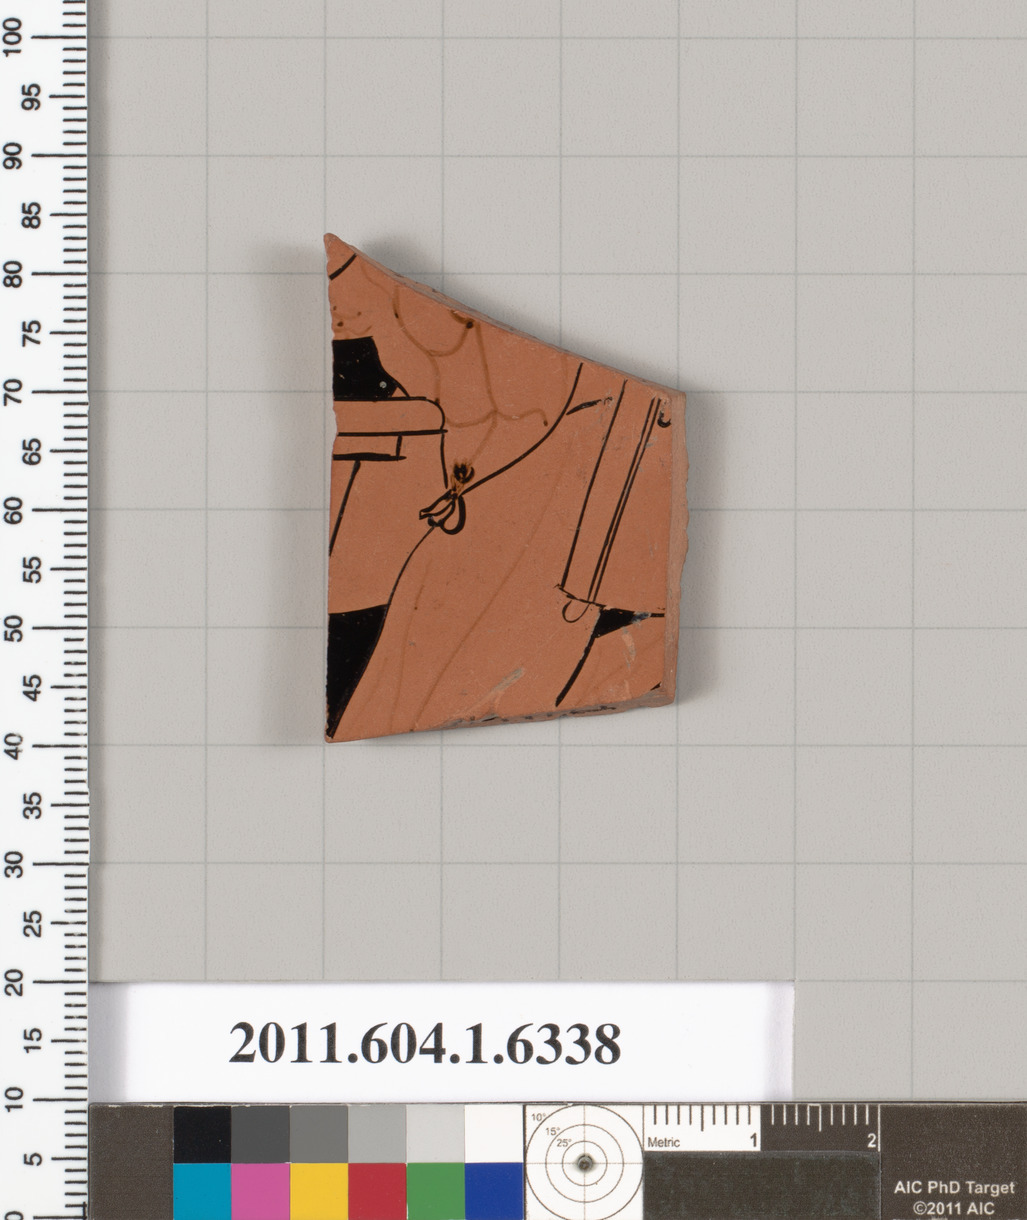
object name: kylix fragment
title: Terracotta fragment of a kylix (drinking cup)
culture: greek, attic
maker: thalia painter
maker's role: artist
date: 500-480 BCE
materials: terracotta